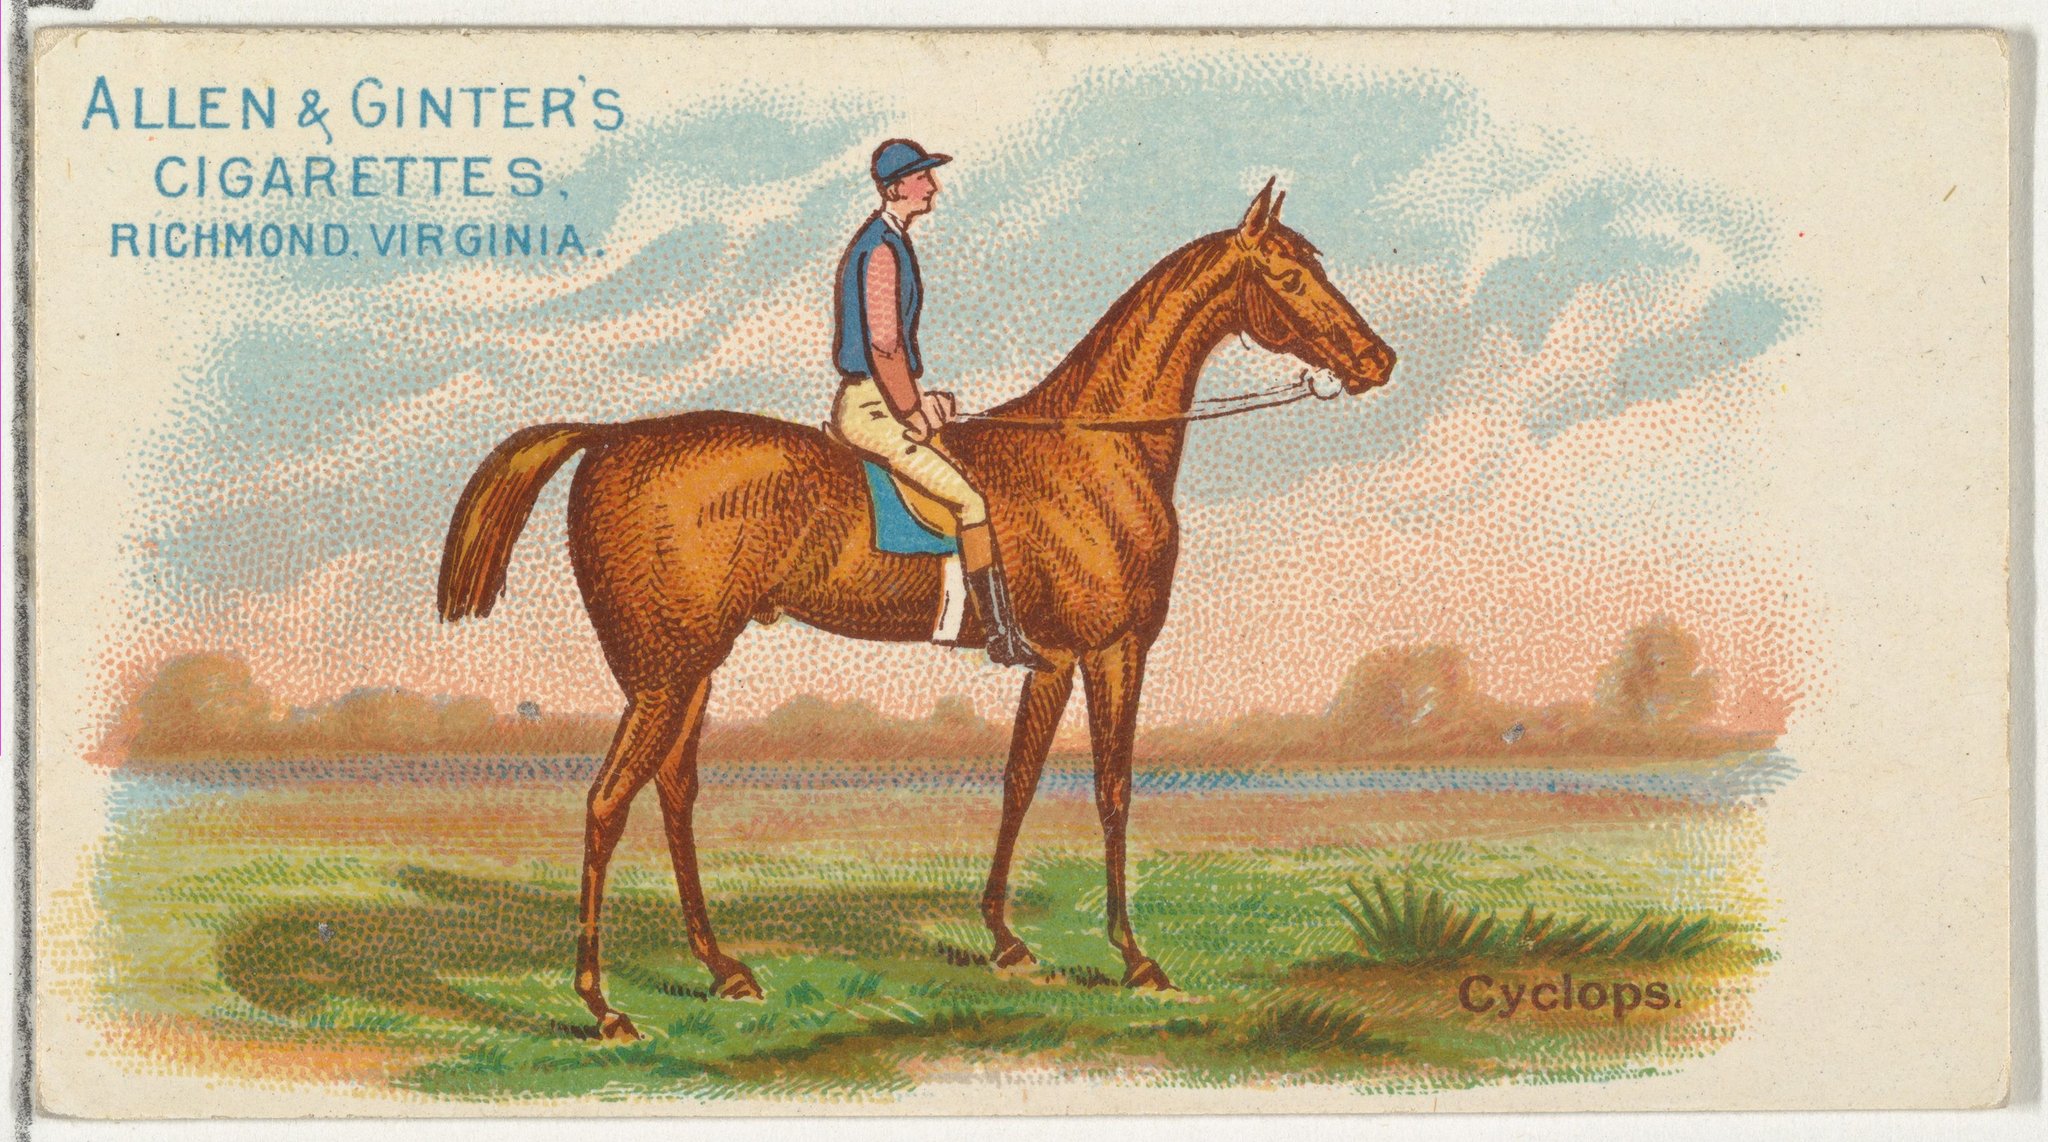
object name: print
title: Cyclops, from The World's Racers series (N32) for Allen & Ginter Cigarettes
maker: allen & ginter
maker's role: publisher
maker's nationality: american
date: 1888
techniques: color lithograph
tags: men,horses,jockeys